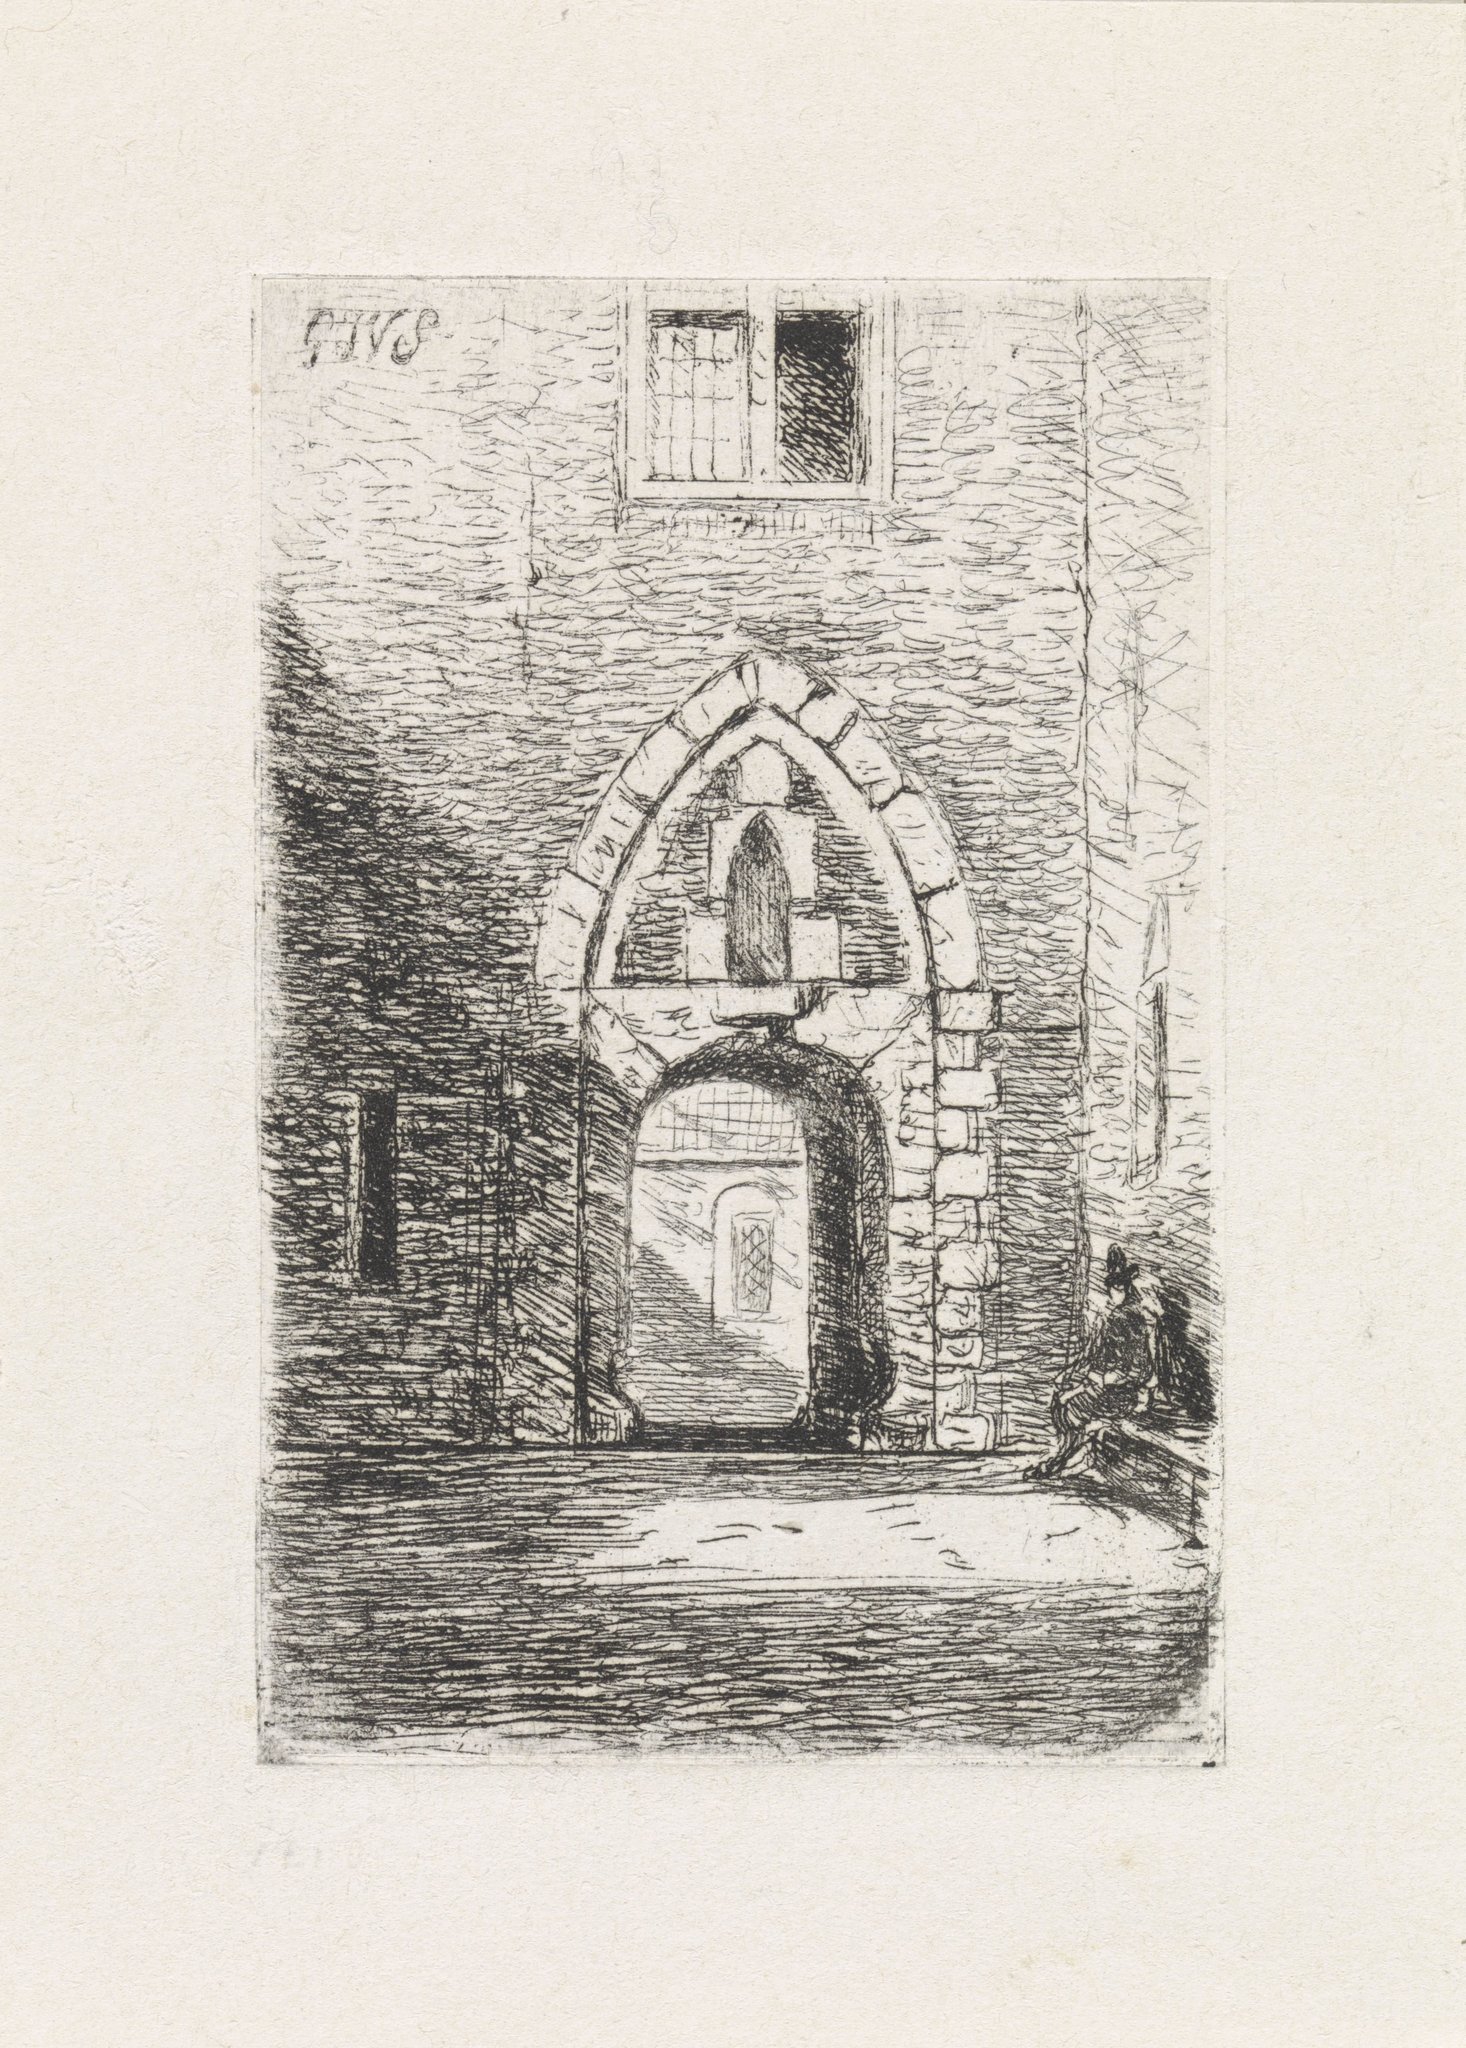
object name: print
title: Gezicht op een poort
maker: gijsbertus johannes verspuy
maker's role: print maker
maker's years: 1823-1862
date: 1833-1862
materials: paper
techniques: etching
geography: netherlands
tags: gate, entrance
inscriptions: collector's mark: Lugt 2228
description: Gezicht op een poort. Links een zittende figuur op een bank.